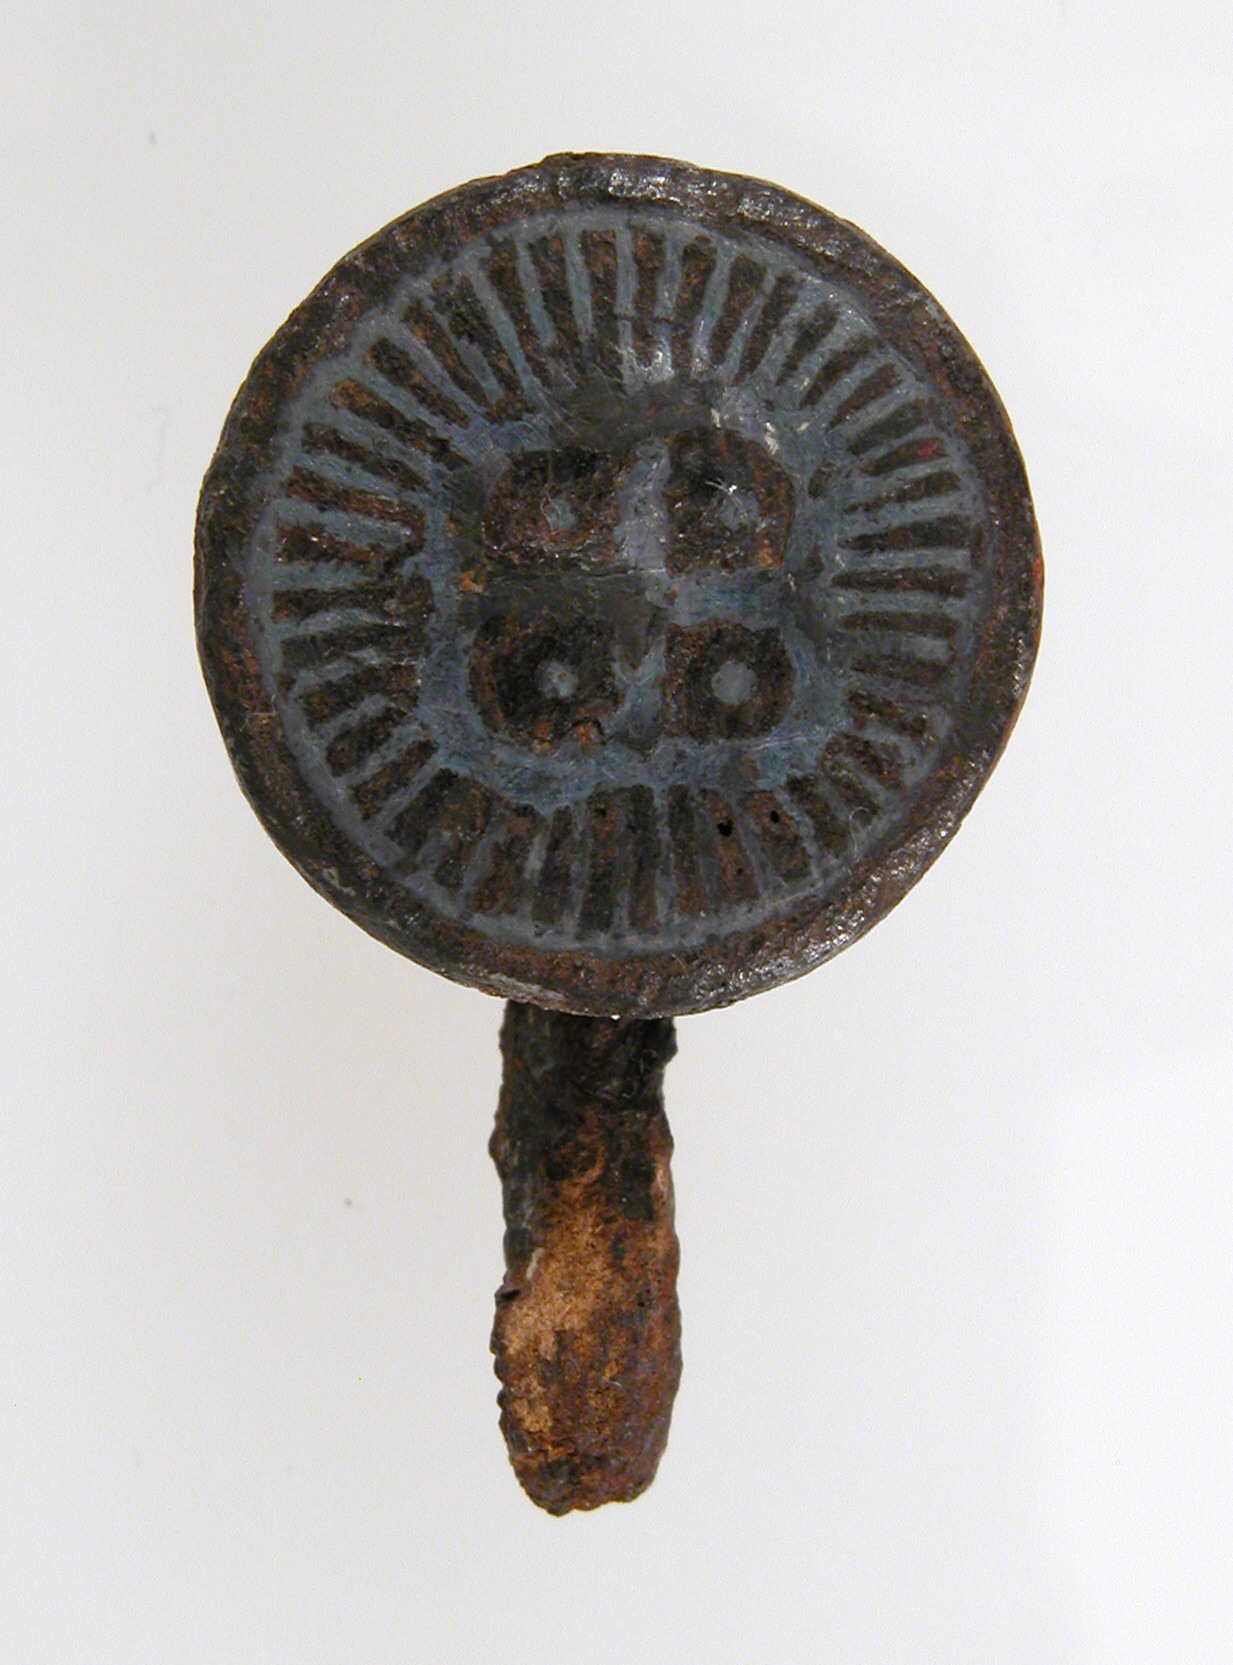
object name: nail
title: Belt Fitting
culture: frankish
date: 601-700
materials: iron, silver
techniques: inlay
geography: northern france